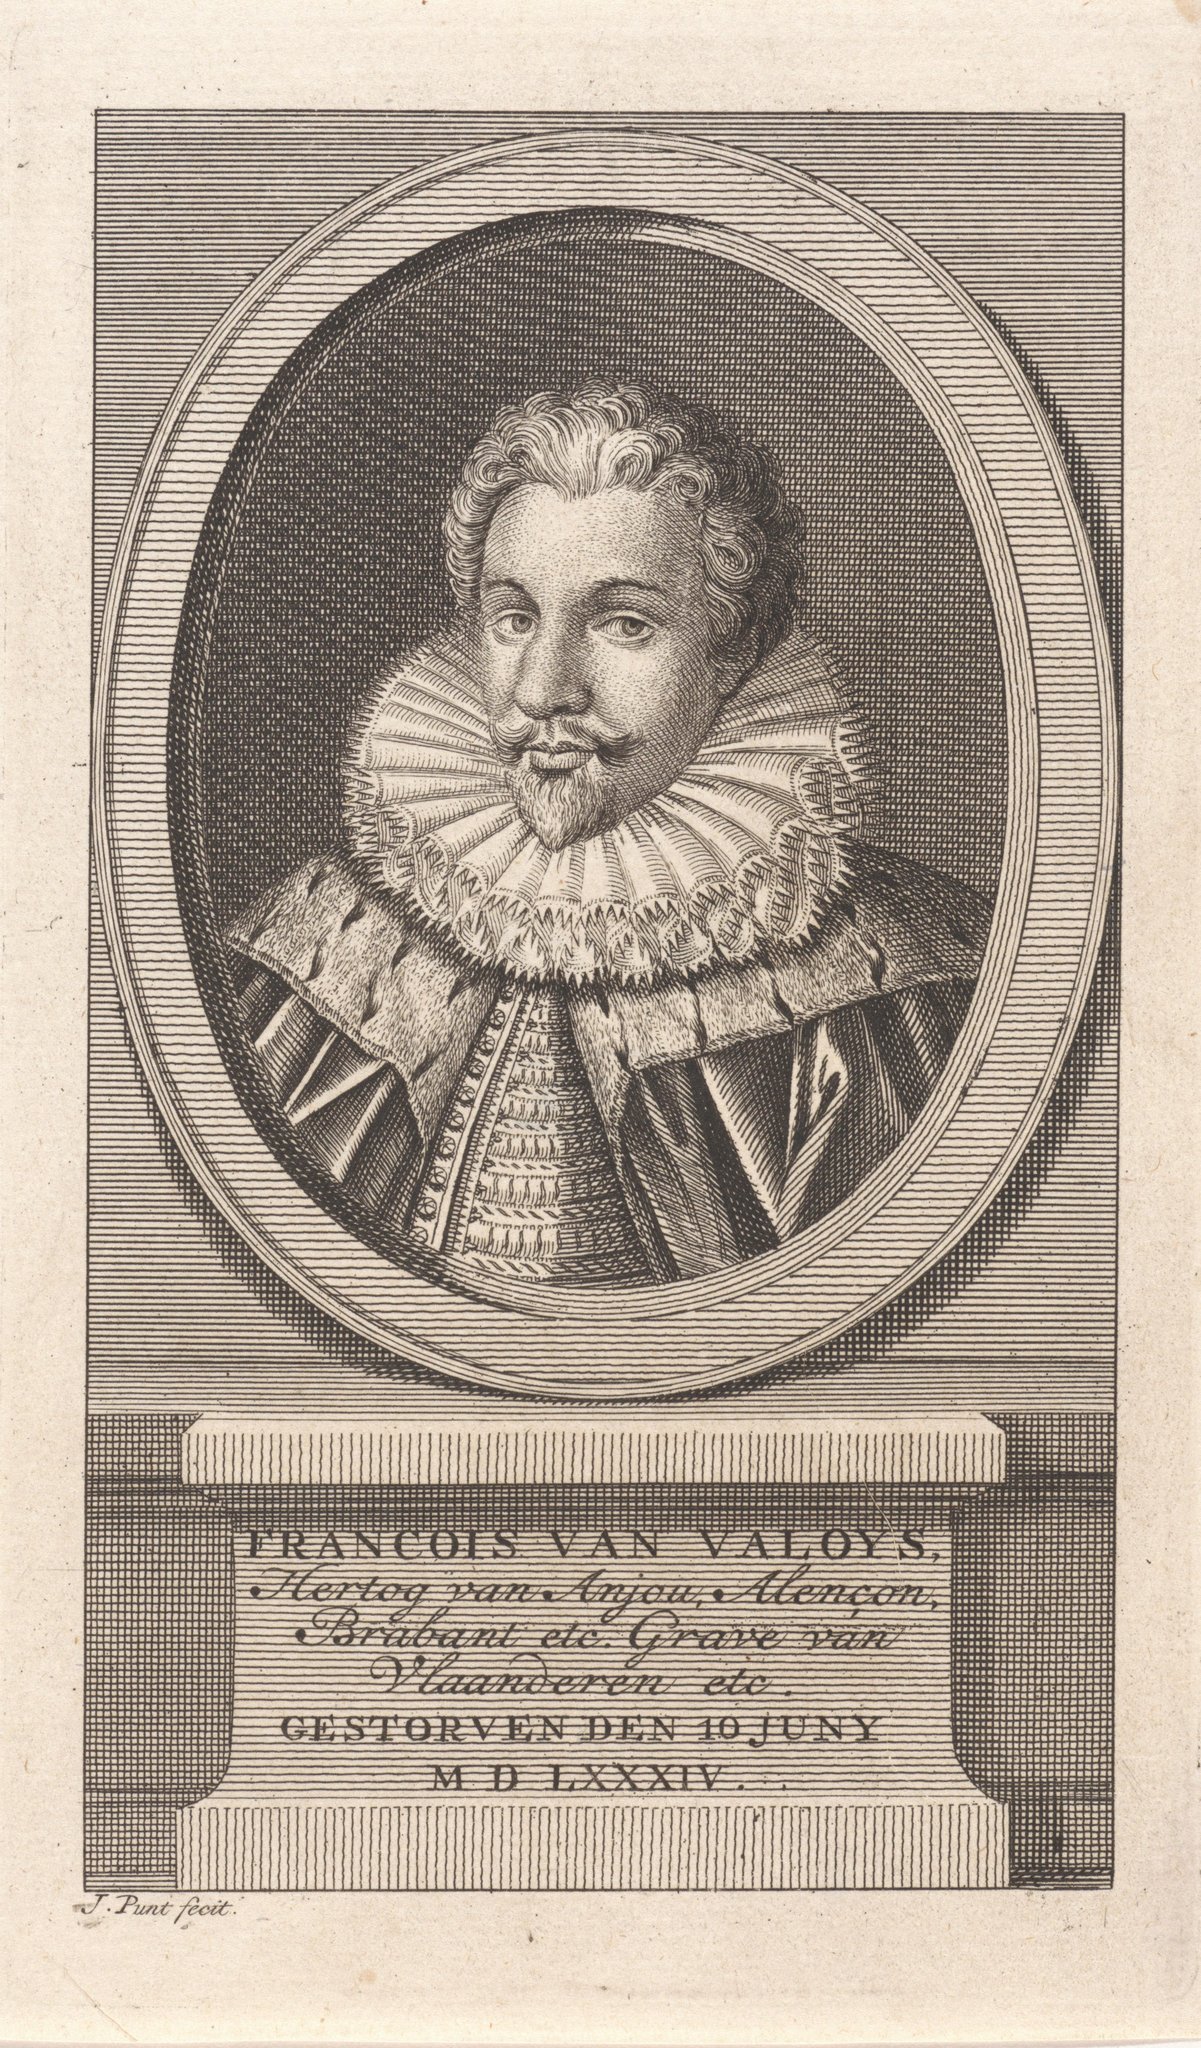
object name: print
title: Portret François-Hercule van Valoys, hertog van Anjou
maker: jan punt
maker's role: draughtsman, print maker, publisher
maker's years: 1711-1779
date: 1786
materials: paper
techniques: engraving, etching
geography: northern netherlands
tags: paris, françois-hercule de valois (hertog van anjou)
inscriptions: collector's mark: Lugt 2228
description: Prent gebruikt als illustratie in: Meteren, Emanuel van. Oorlogen en geschiedenissen der Nederlanderen en derzelver nabuuren, deel IV, p. 5. Amsterdam: Steven Jacobus Baalde, 1786.